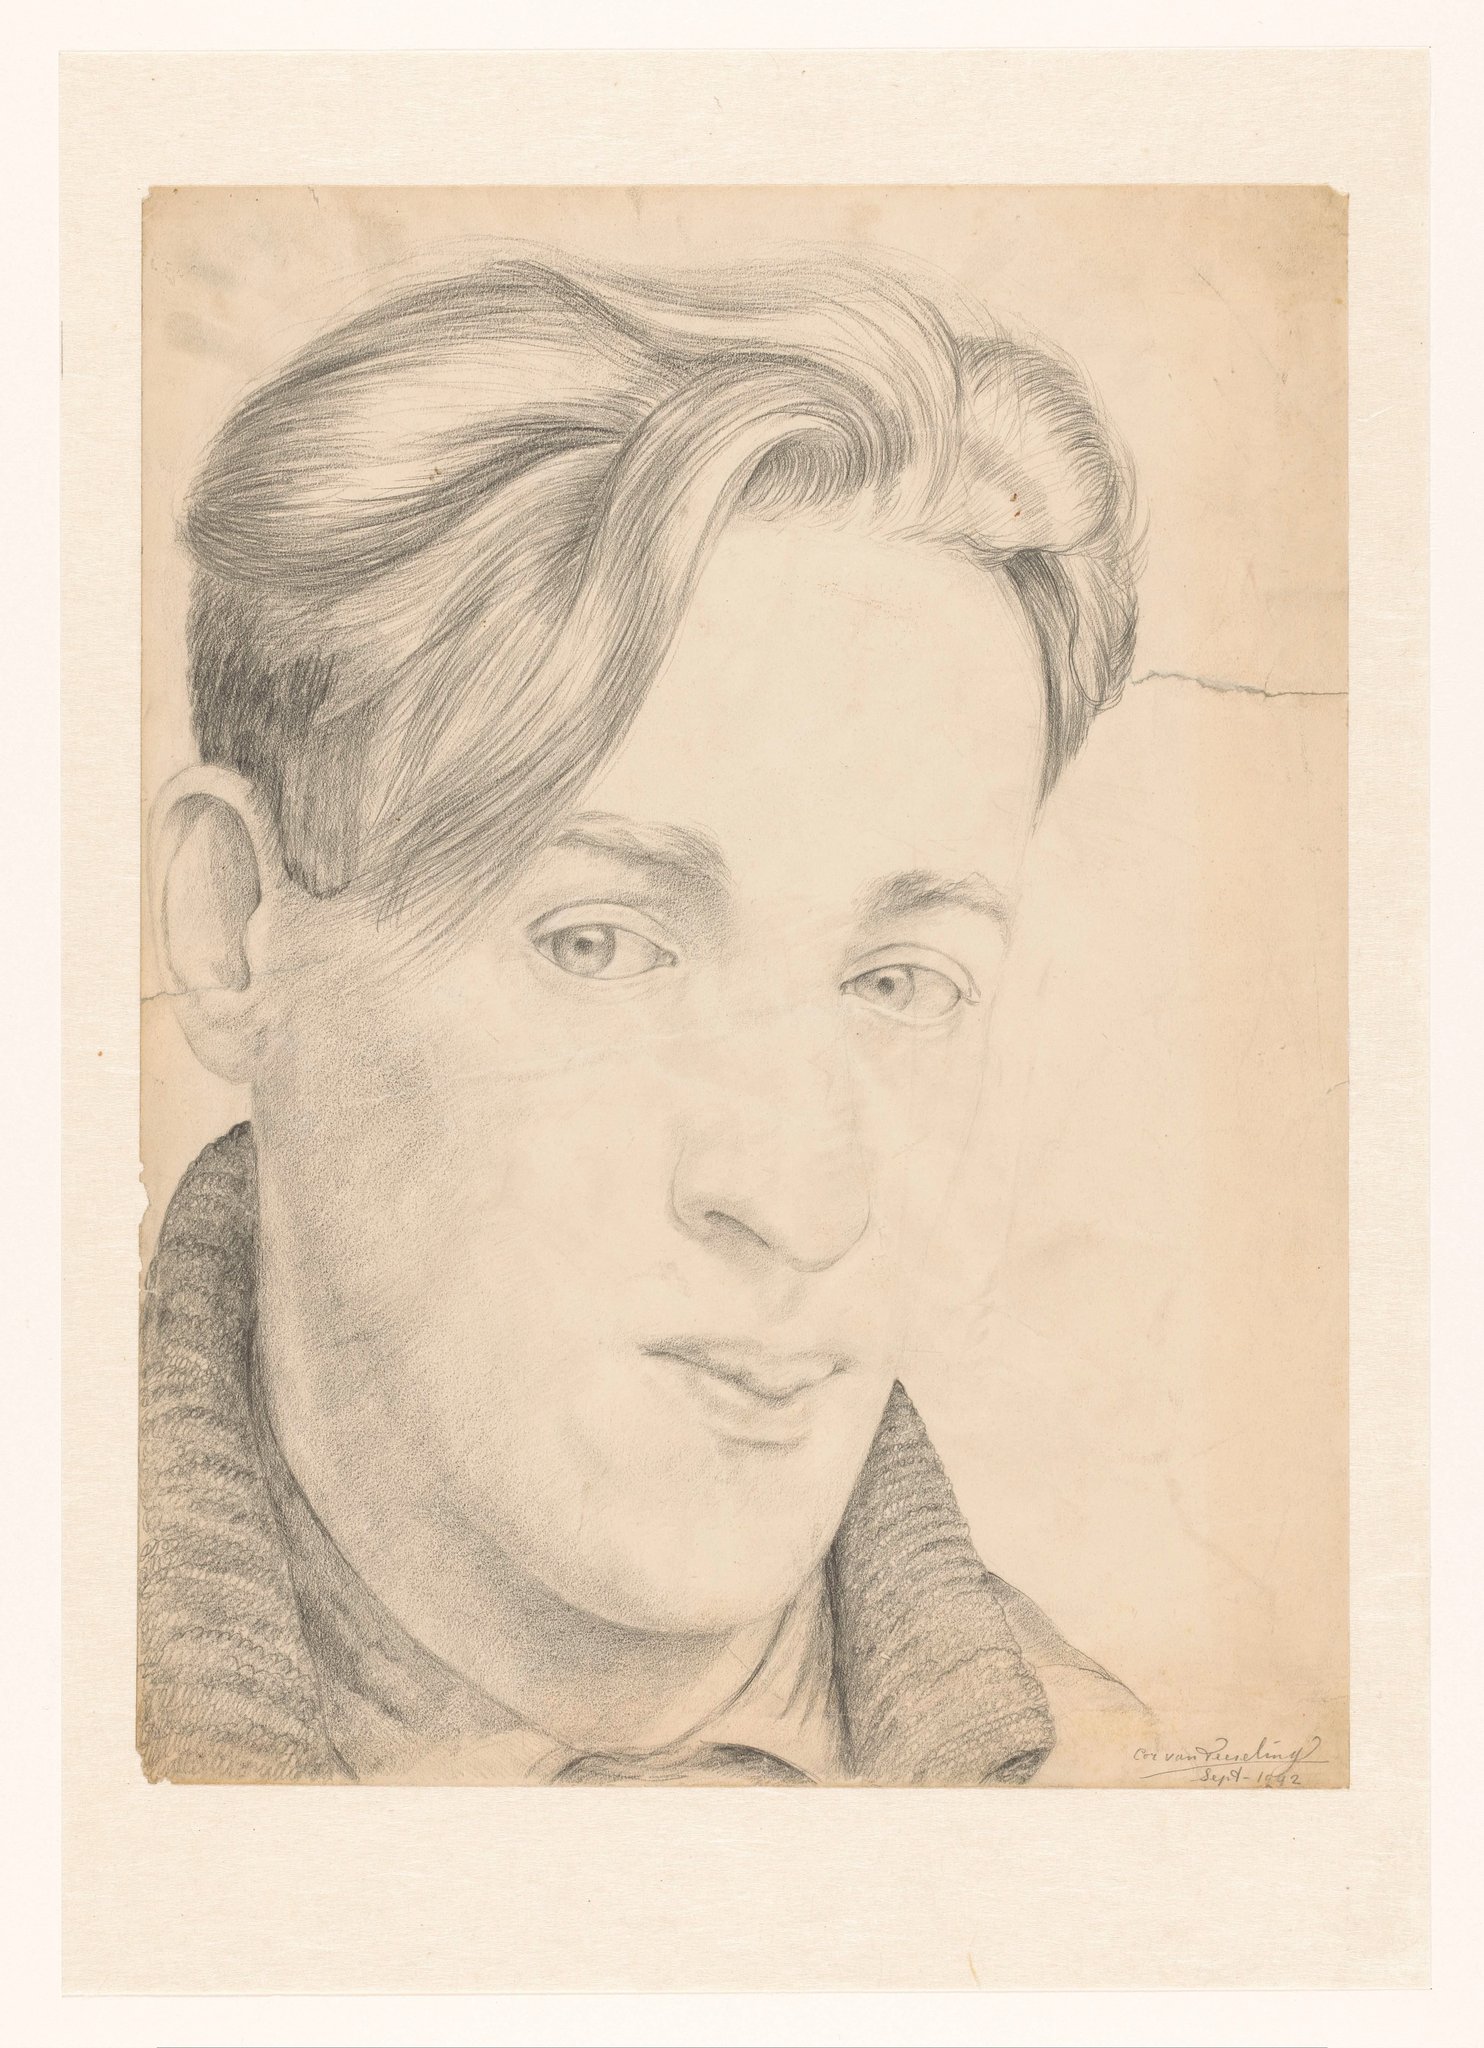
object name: drawing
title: Zelfportret, september 1942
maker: cor van teeseling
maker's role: draughtsman, sculptor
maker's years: 1915-1942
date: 1909-1942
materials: paper, pencil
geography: amsterdam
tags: amsterdam, sculptor, cor van teeseling, historical persons, prisoner in cell or locked place, portrait, self-portrait of draughtsman, netherlands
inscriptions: signature and date: ‘Cor van Teeseling / sept 1942’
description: Zelfportret van Cor van Teeseling, september 1942. Zelfportret van Van Teeseling, zijn haar valt deels over zijn voorhoofd en hij heeft zijn gezicht naar rechts gewend. Gedateerd Sept. 1942.